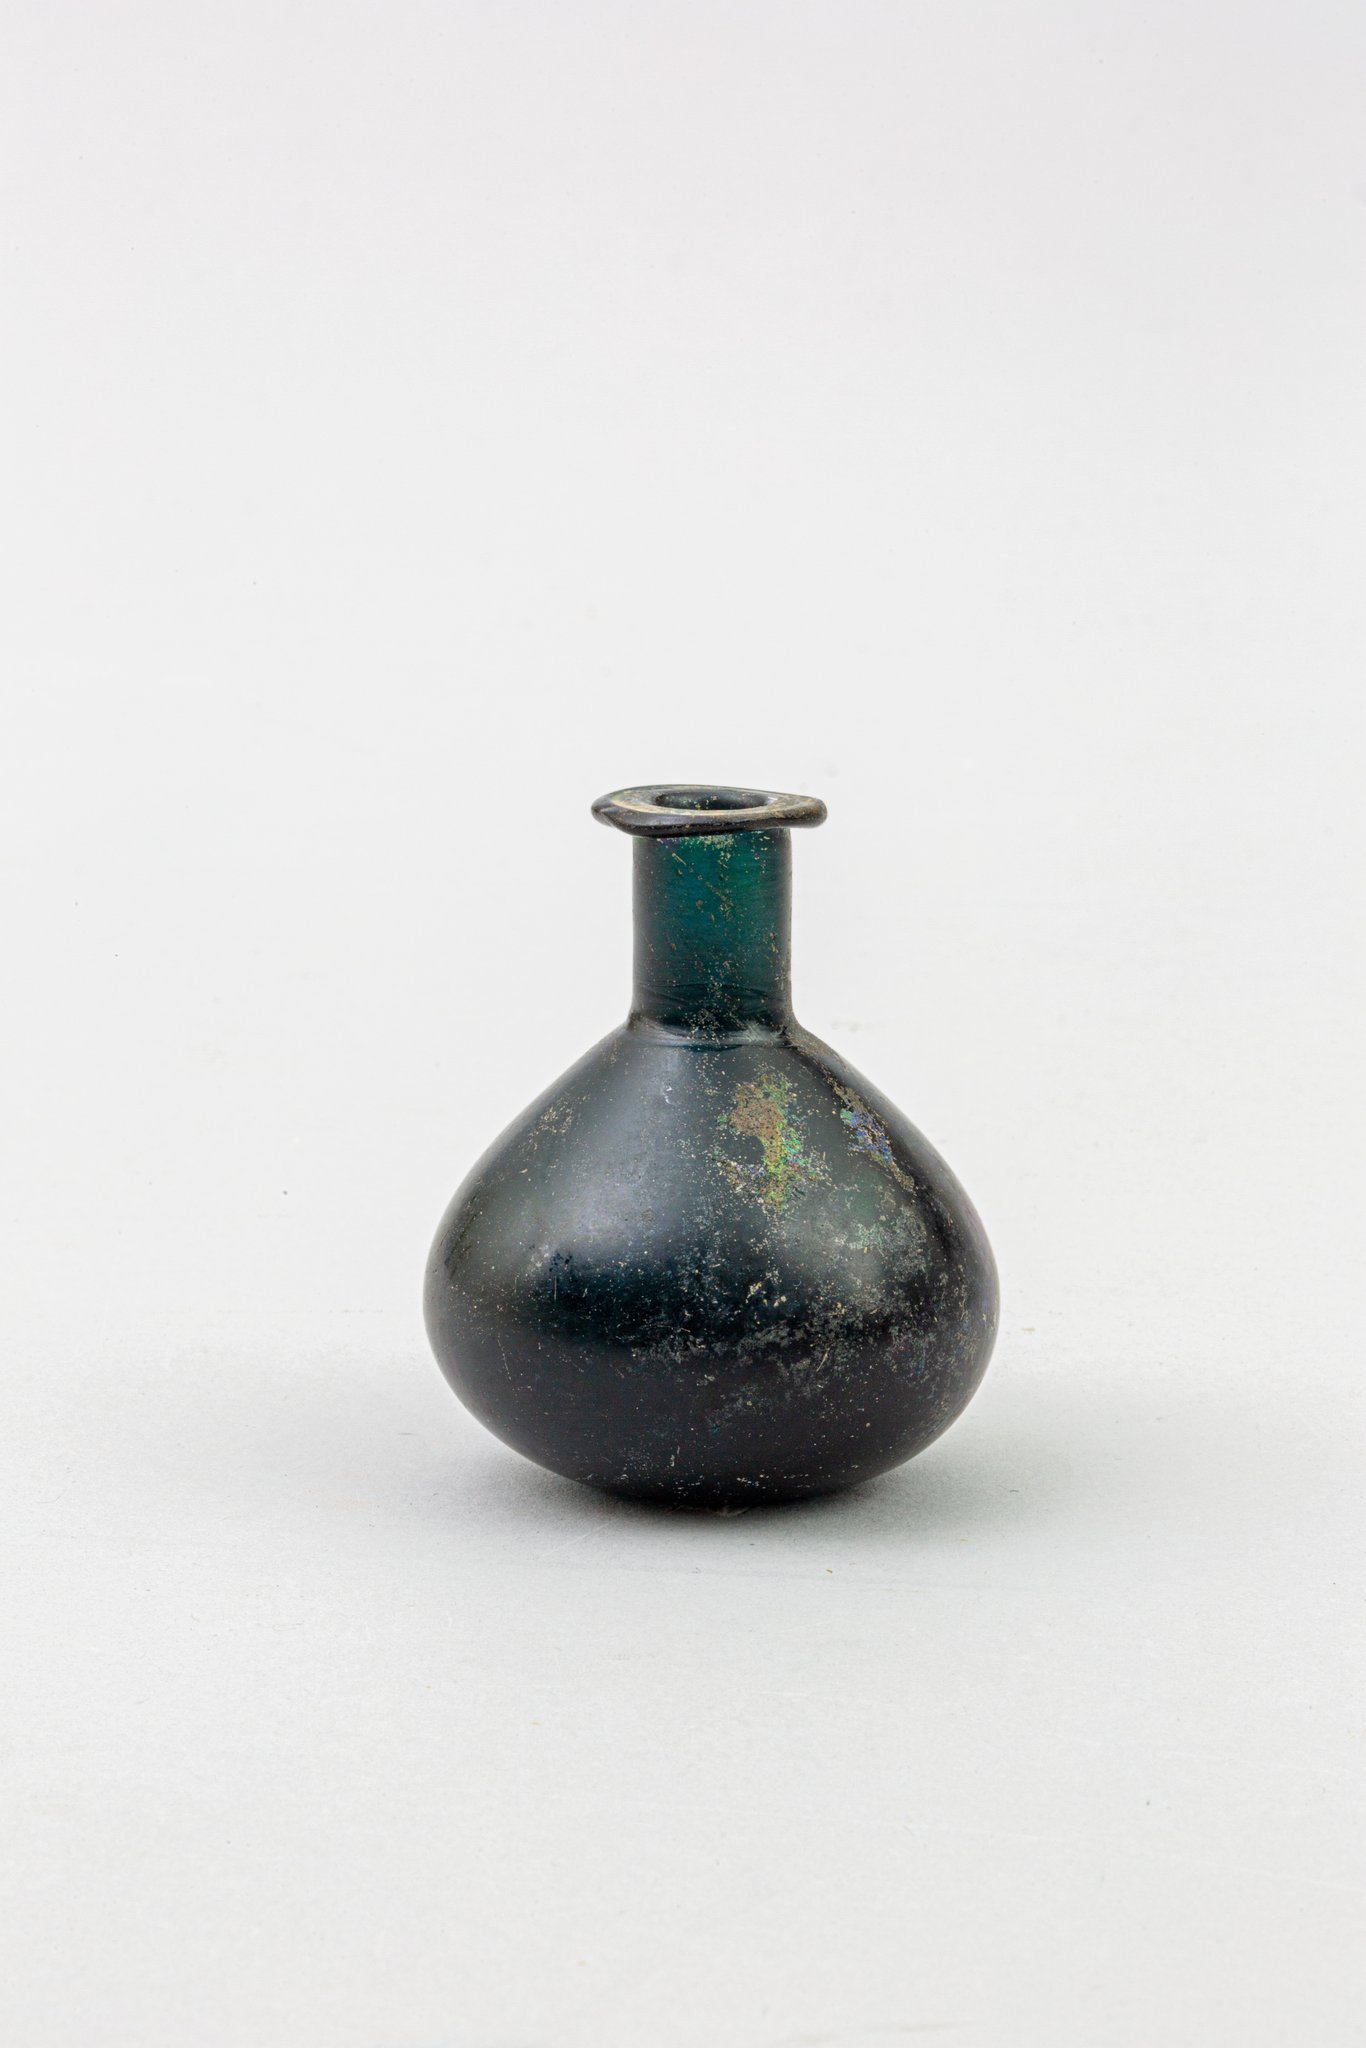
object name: perfume bottle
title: Glass perfume bottle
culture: roman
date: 1-50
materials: glass